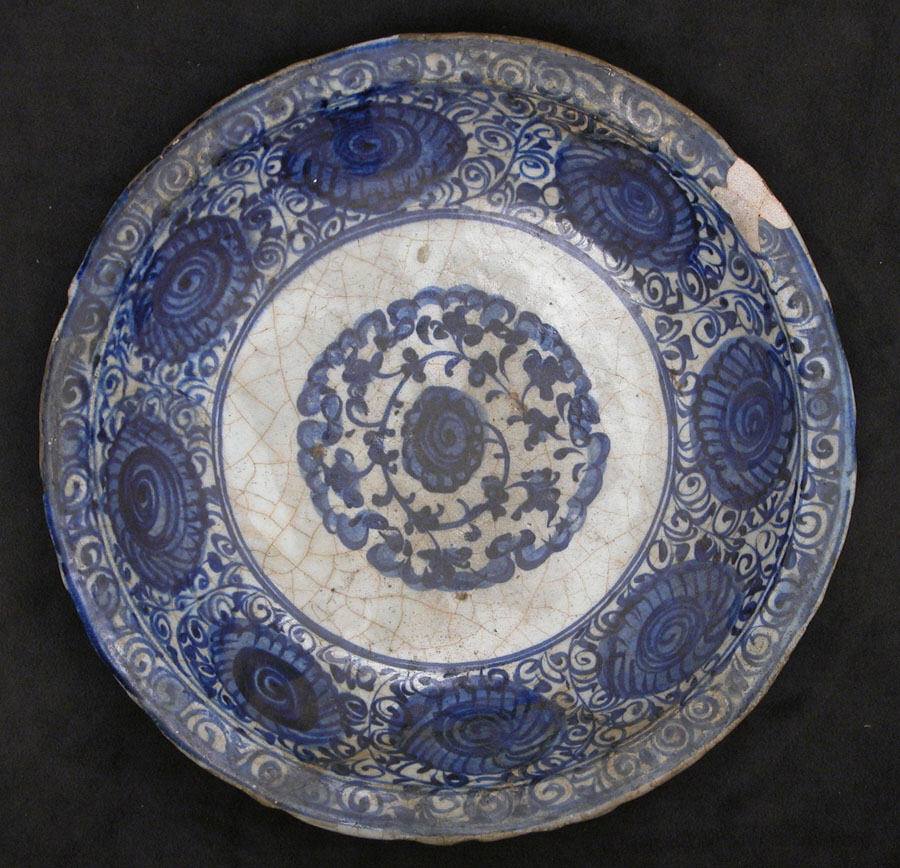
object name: dish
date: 1501-1600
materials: stonepaste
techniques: glazing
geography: iran